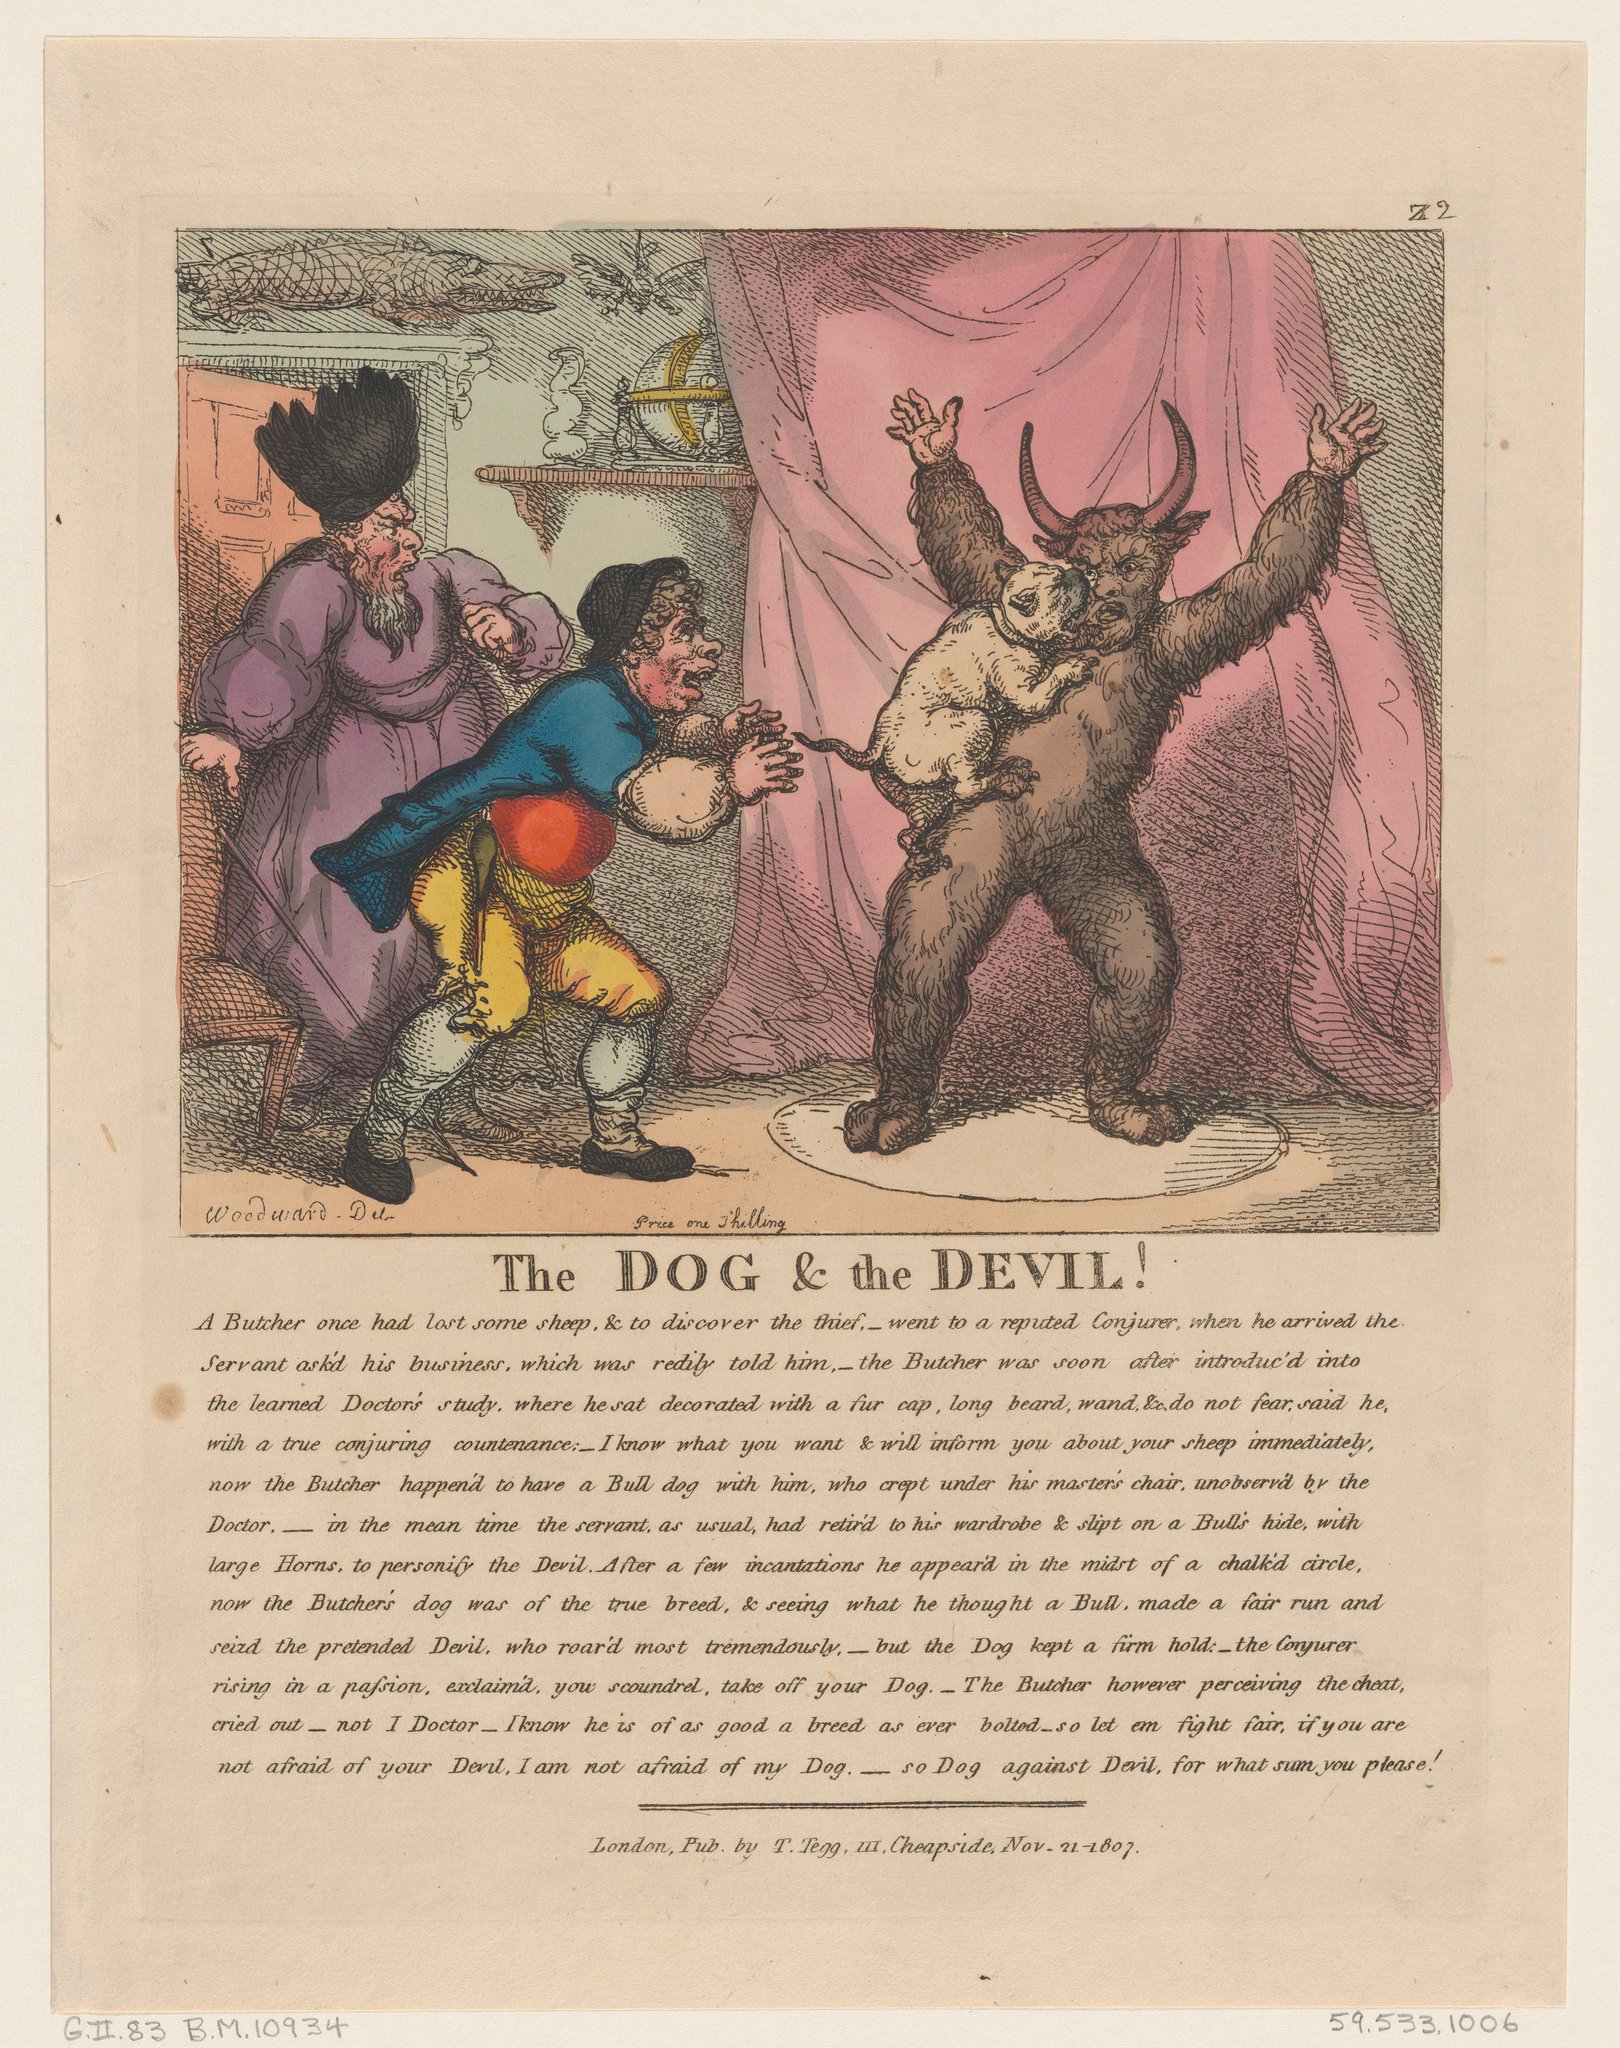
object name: print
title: The Dog & The Devil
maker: thomas rowlandson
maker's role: artist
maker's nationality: british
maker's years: 1757-1827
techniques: etching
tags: men,dogs,devil